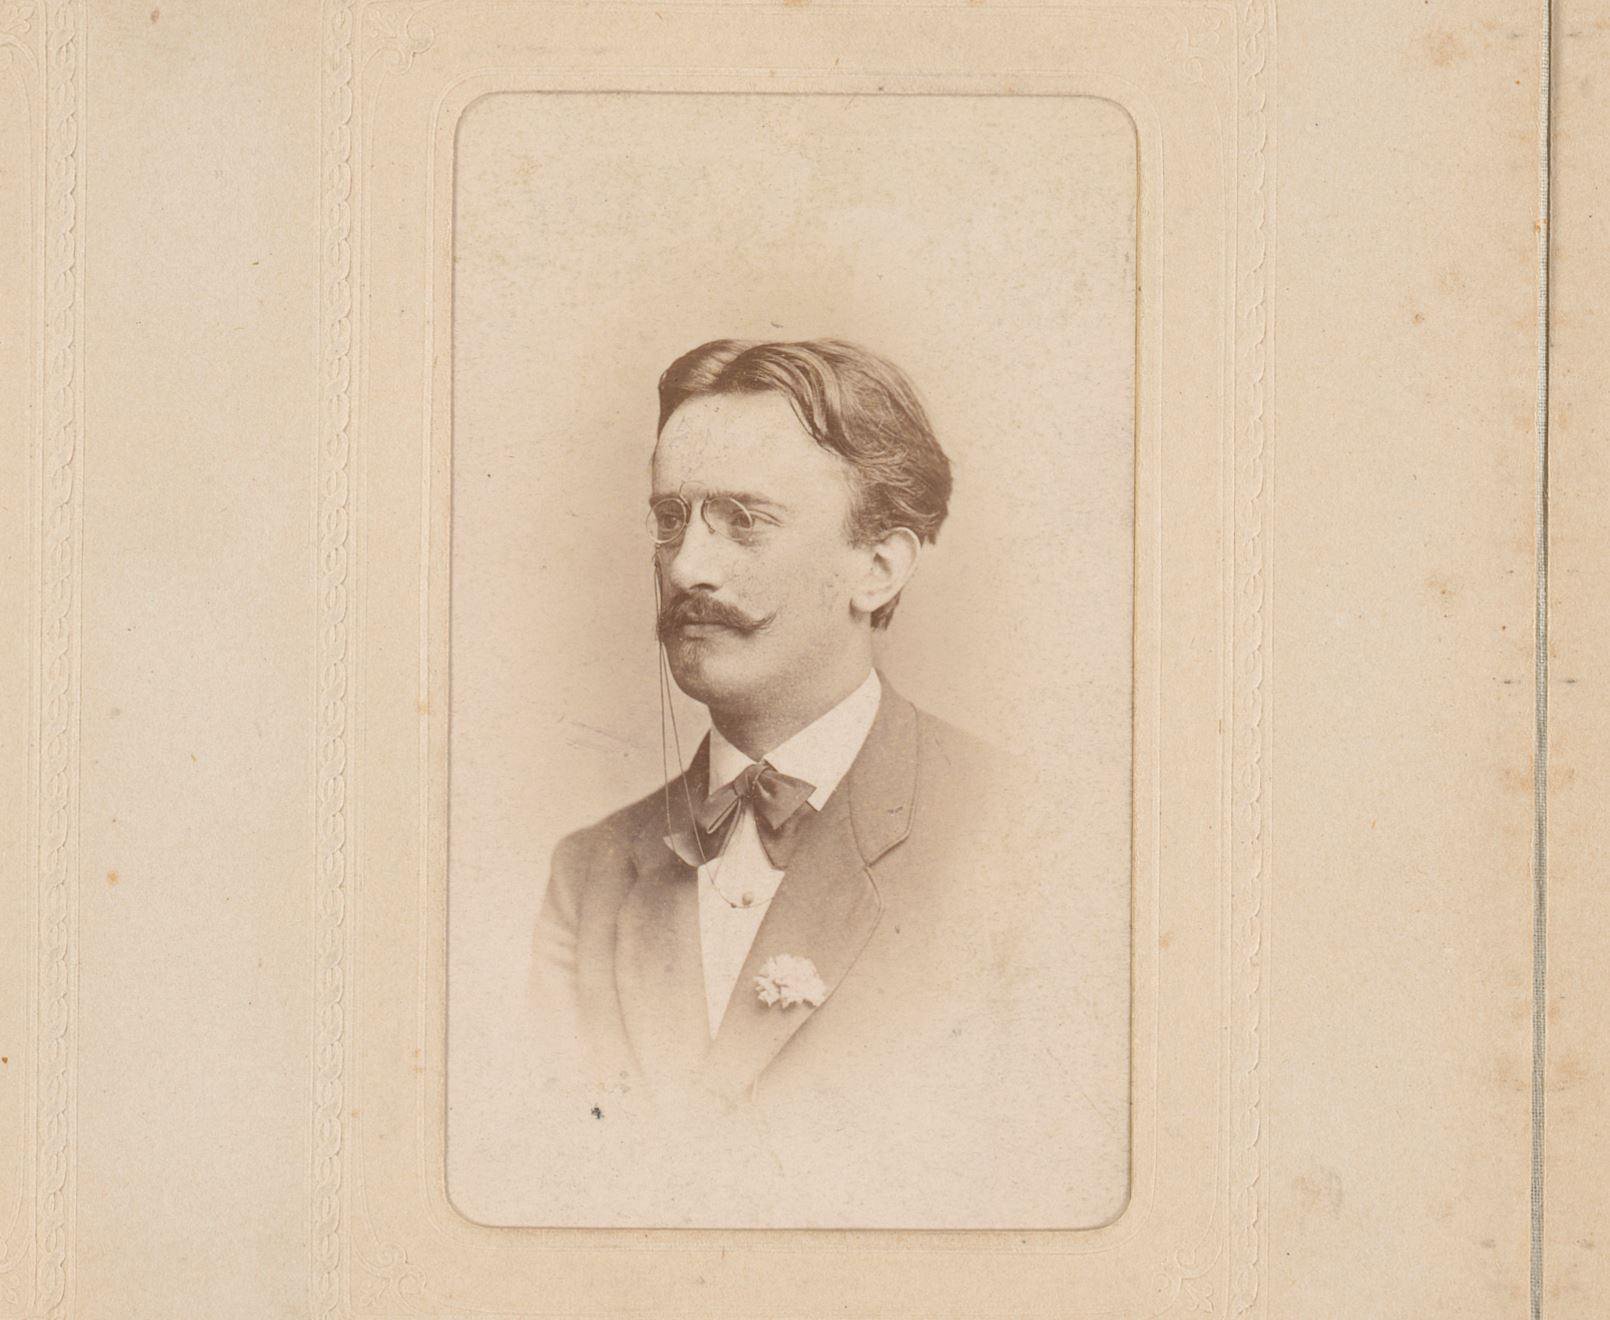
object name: carte de visite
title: Portret van een man met snor, bril en vlinderstrik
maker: j. tomáš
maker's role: fotograaf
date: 1860-1900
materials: cardboard, photographic support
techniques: albumen print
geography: prague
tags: eyeglasses, spectacles, moustache, historical persons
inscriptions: annotation: ‘Otok[..] Rarar[..]/ AK’, inscription: ‘J. TOMÁŠ/ fotograf a techn. lucebnik/ sv. Vacslavske námesti/ v/ PRAZ/ cislo/ Fotograf u. techn. Chemikrn/ St. Wenzels Platz/ in/ PRAG/ Nro/ 7./’